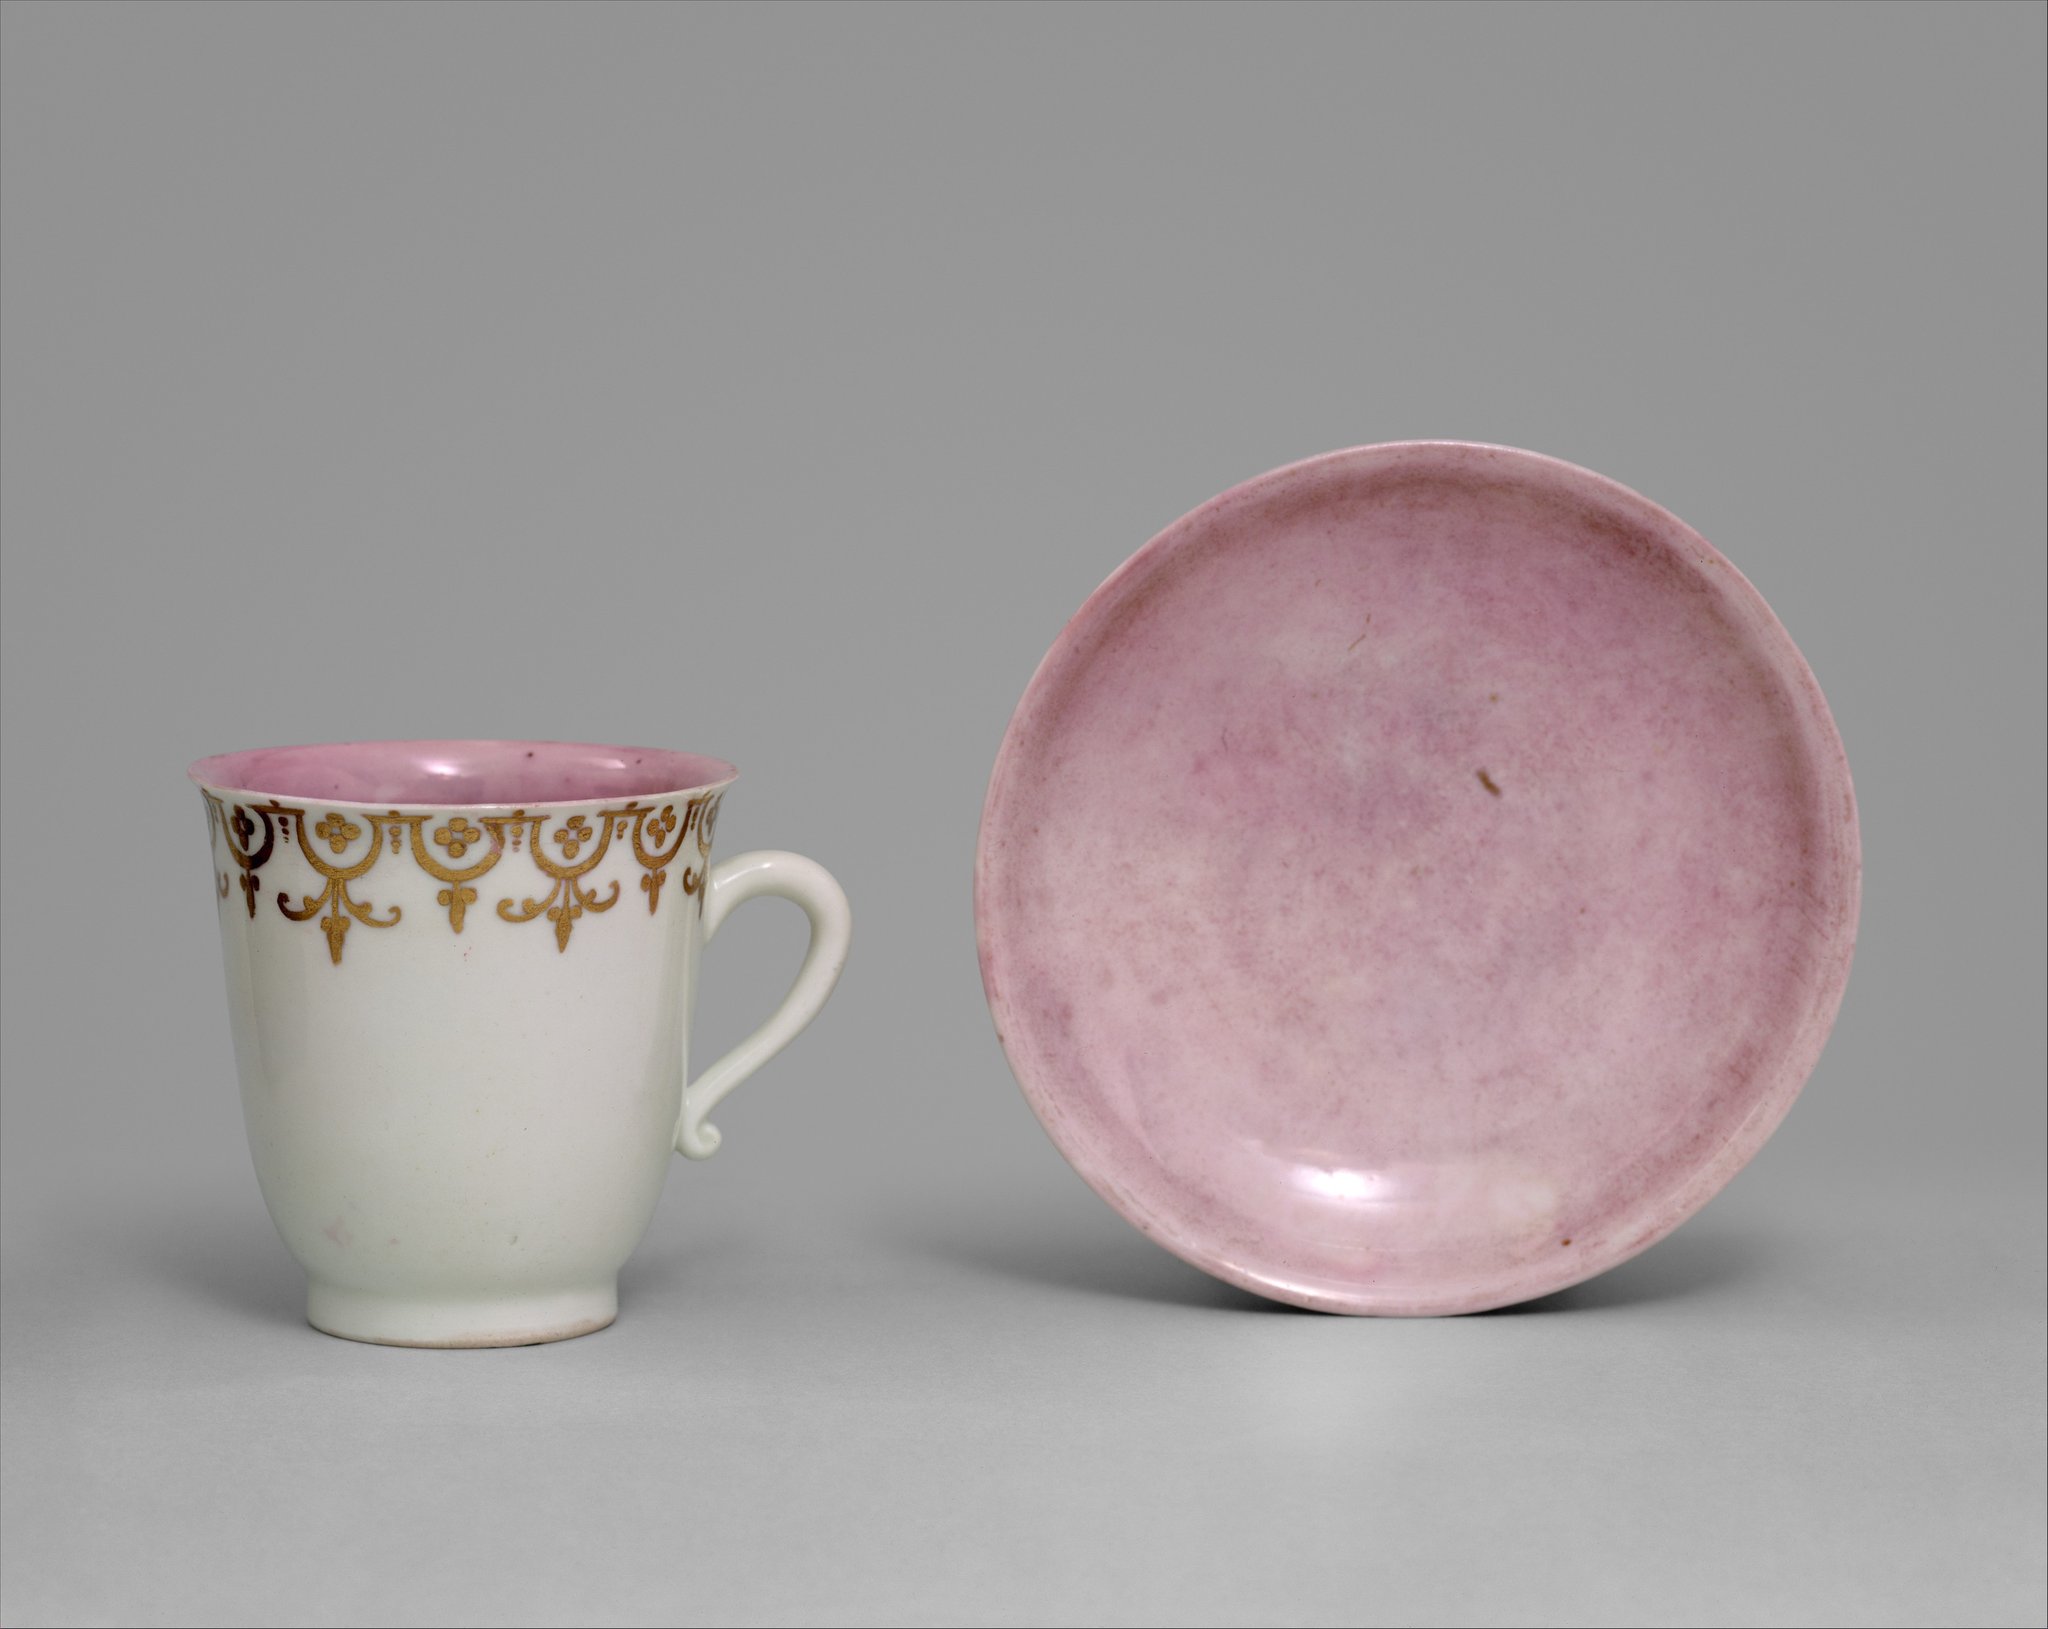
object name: cup and saucer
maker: meissen manufactory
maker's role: manufactory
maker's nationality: german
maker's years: 1710-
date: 1717-1720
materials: hard paste porcelain